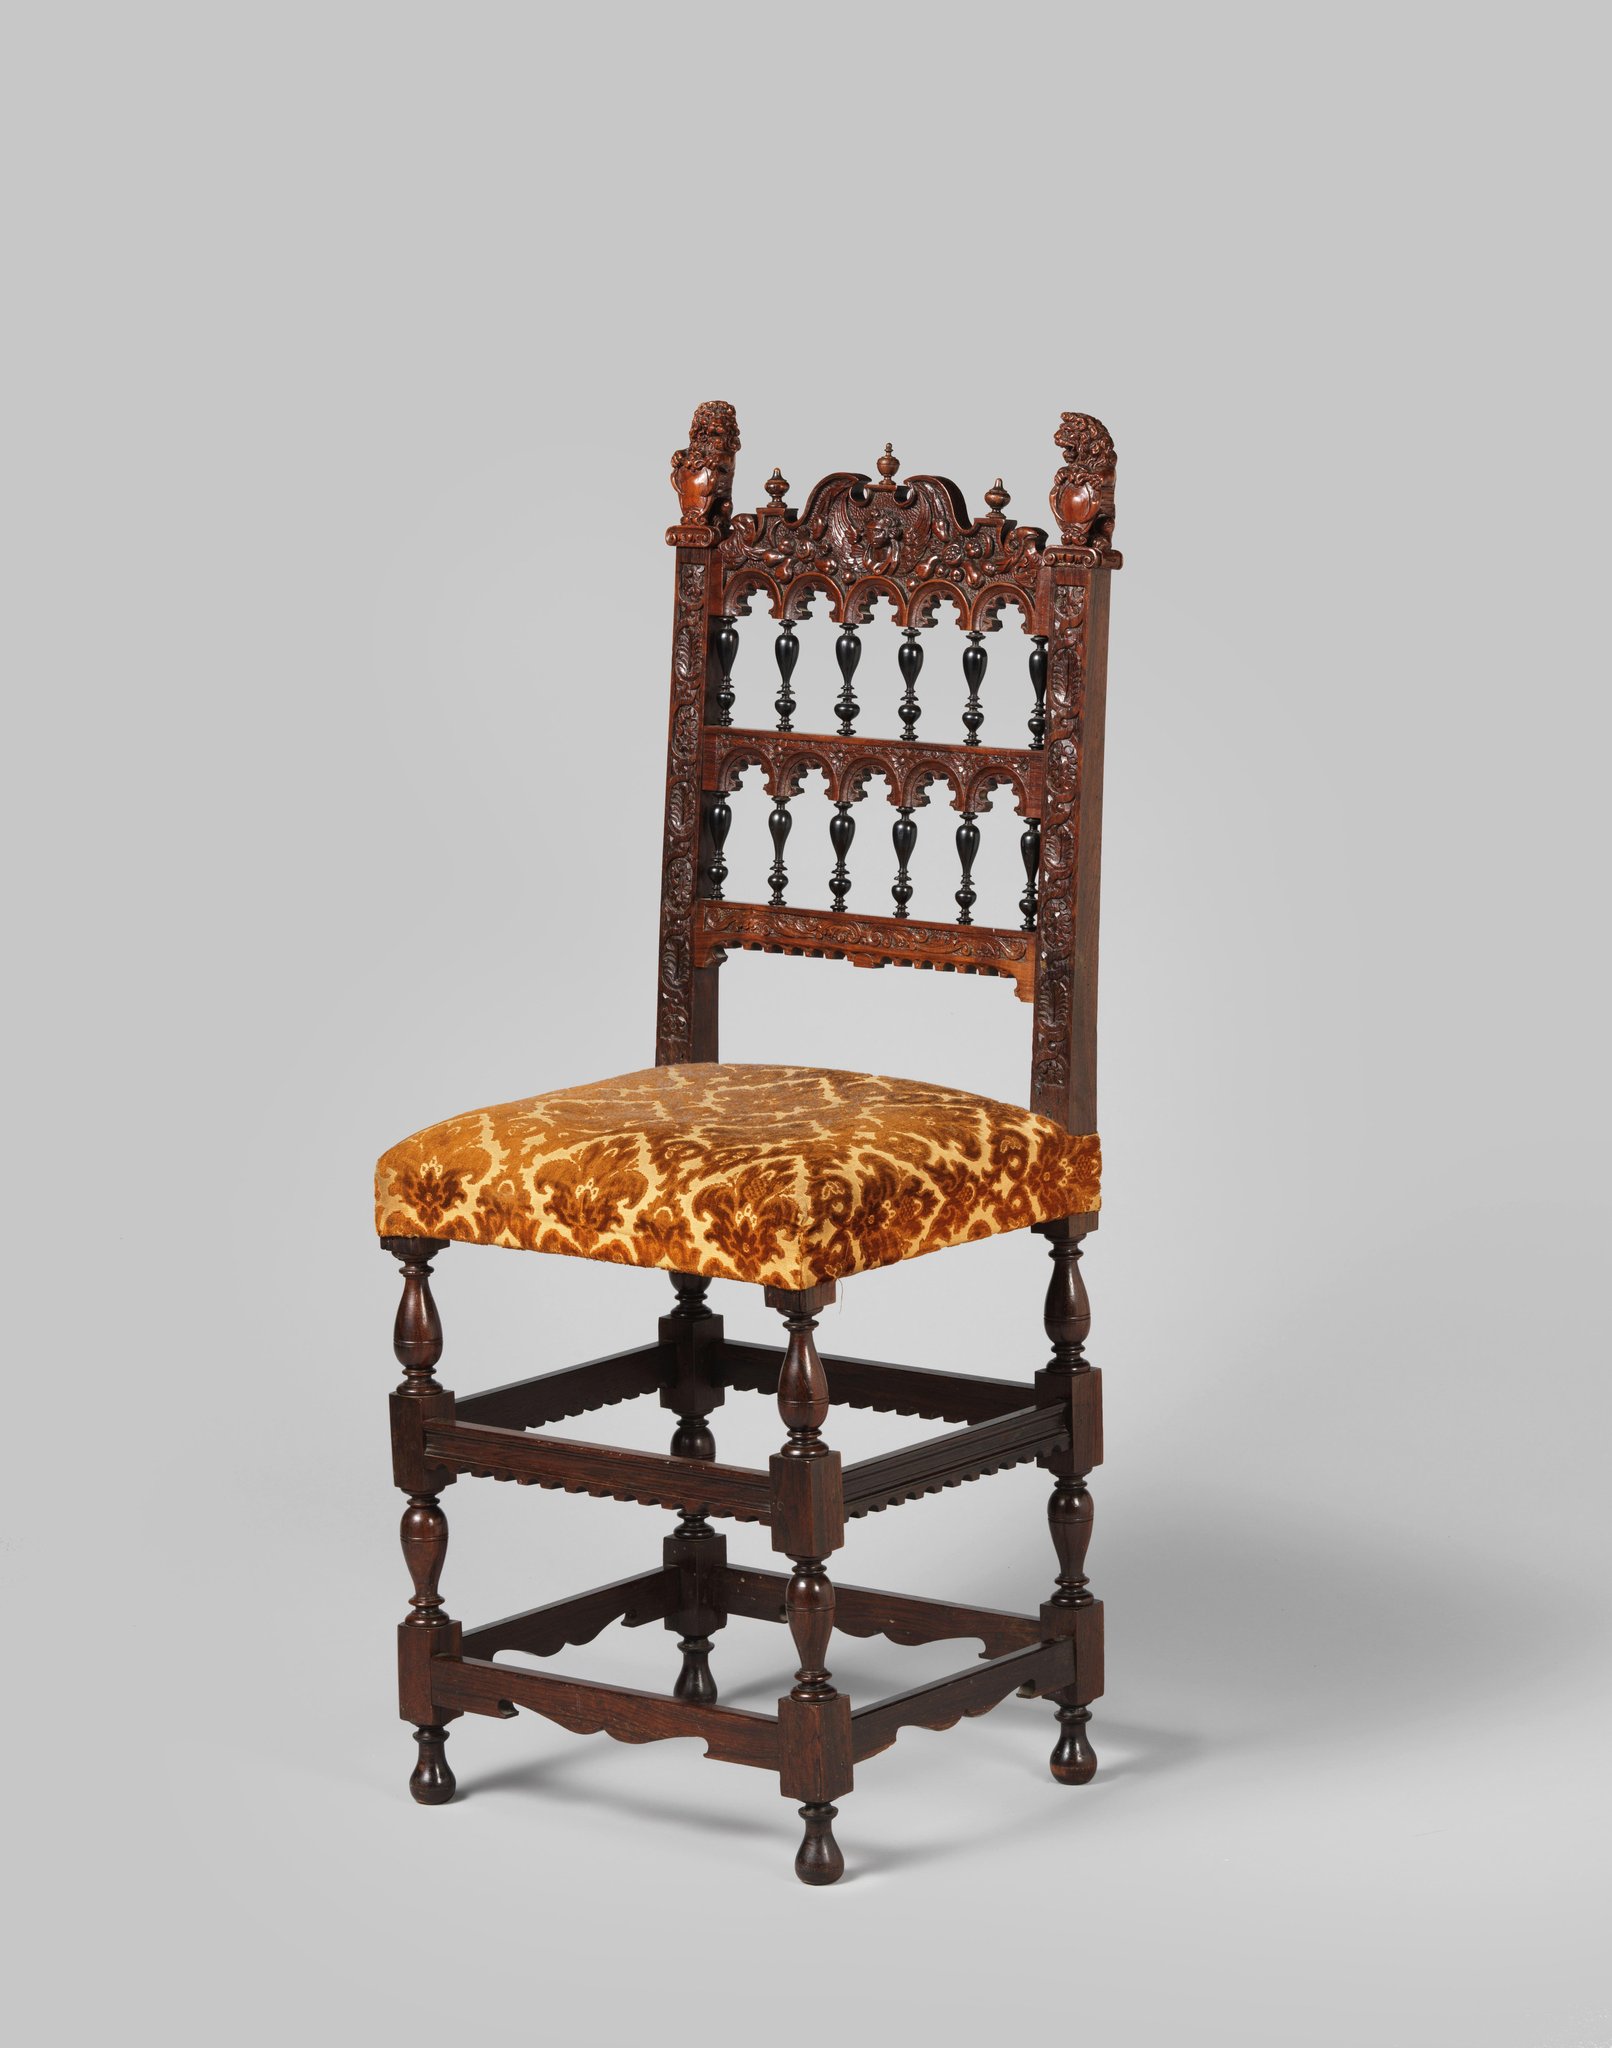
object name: seating furniture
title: Meubilair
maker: Anonymous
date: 1640-1660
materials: wood, textile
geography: northern netherlands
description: Stoel van palissanderhout. Beklede zitting. De poten met huis en geleding zijn verbonden door acht sporten; vier zijn accoladevormig geschulpt en vier met geholde tandlijst. De rugstijlen dragen vlechtband met lussenpatroon met palmet of rozet. De bovenste twee rugsporten hebben aan de onderkant vijf bogen op balusters, verder versierd met rozetten, tandlijst en acanthusblad. De geschulpte bovensport heeft hanekoppen op de hoeken met draperie in de bek en verder een cherub, vruchten en bovenop drie vaasjes.